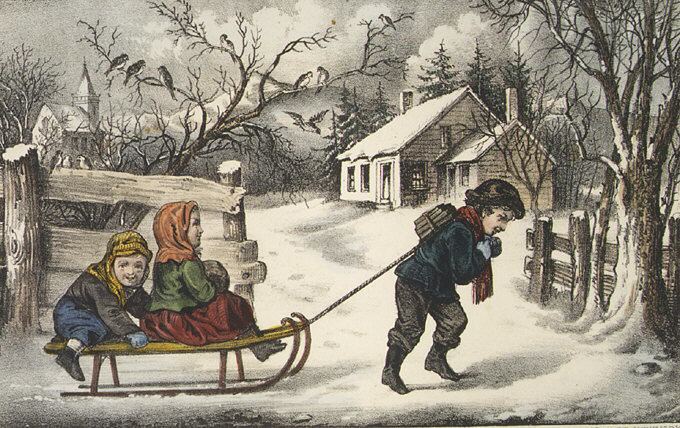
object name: print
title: A Ride to School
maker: currier & ives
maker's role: publisher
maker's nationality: american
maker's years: 1857-1907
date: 1868-1878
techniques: hand coloring, lithograph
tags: boys,girls,sledging,winter,snow